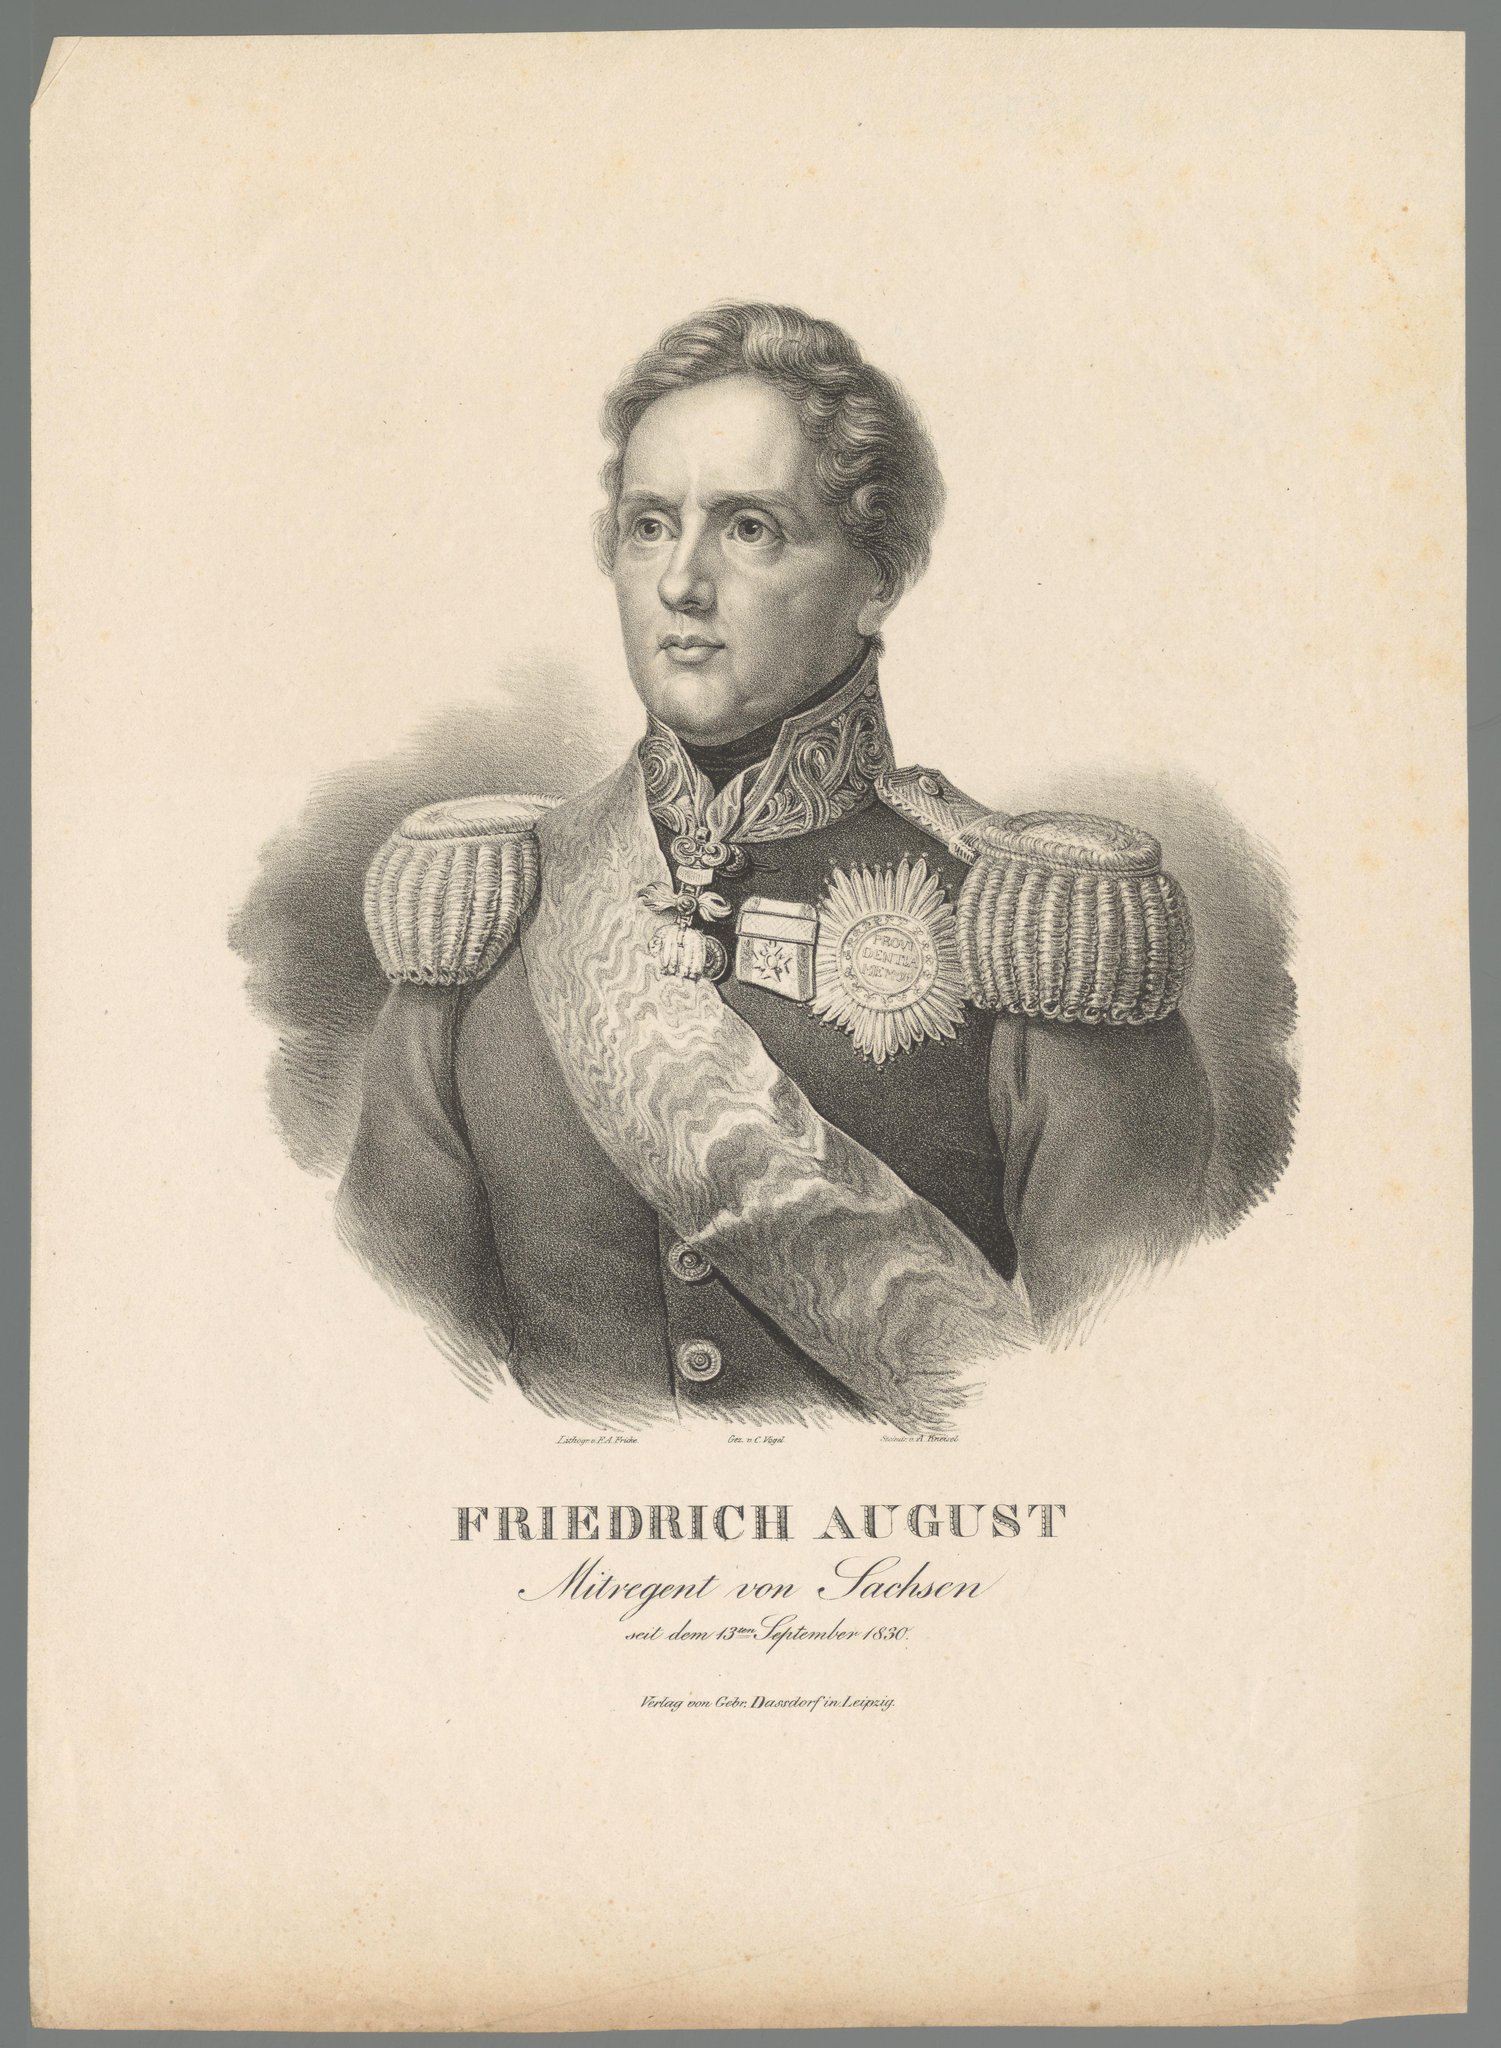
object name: print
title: Friedrich August Mitregent von Sachsen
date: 1758-1858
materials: paper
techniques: lithograph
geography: leipzig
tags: adult man, historical persons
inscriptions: collector's mark: Lugt 2228